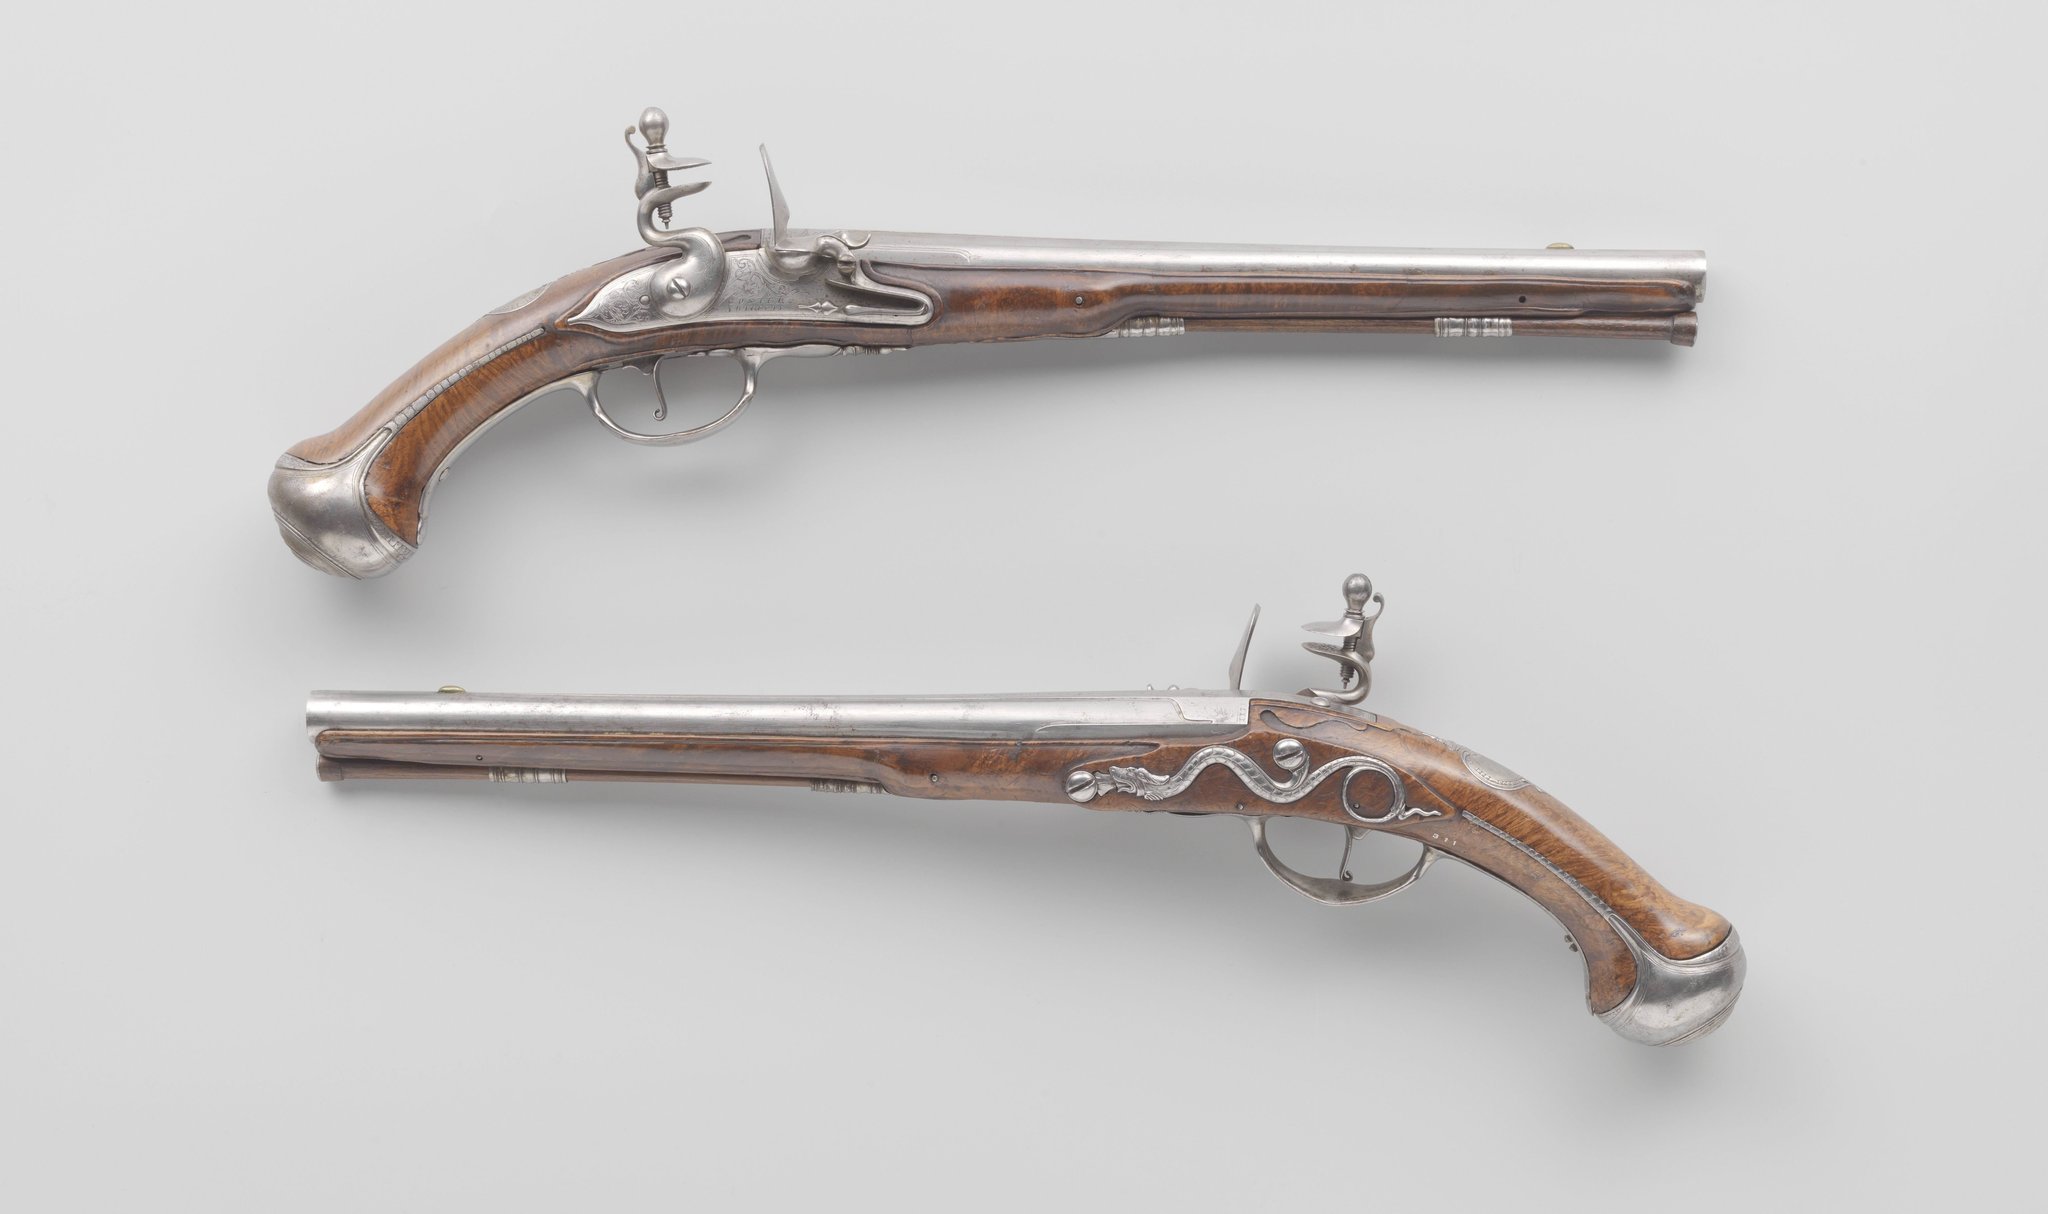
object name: flintlock pistol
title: Vuursteenpistool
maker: cornelis coster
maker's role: geweermaker, pistoolmaker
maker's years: -1698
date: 1685-1692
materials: brass, iron, wood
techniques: printing, cutting, engraving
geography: utrecht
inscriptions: inscription: ‘COSTER // A UTRECHT’, inscription: ‘COSTER A UTRECHT’, coat of arms